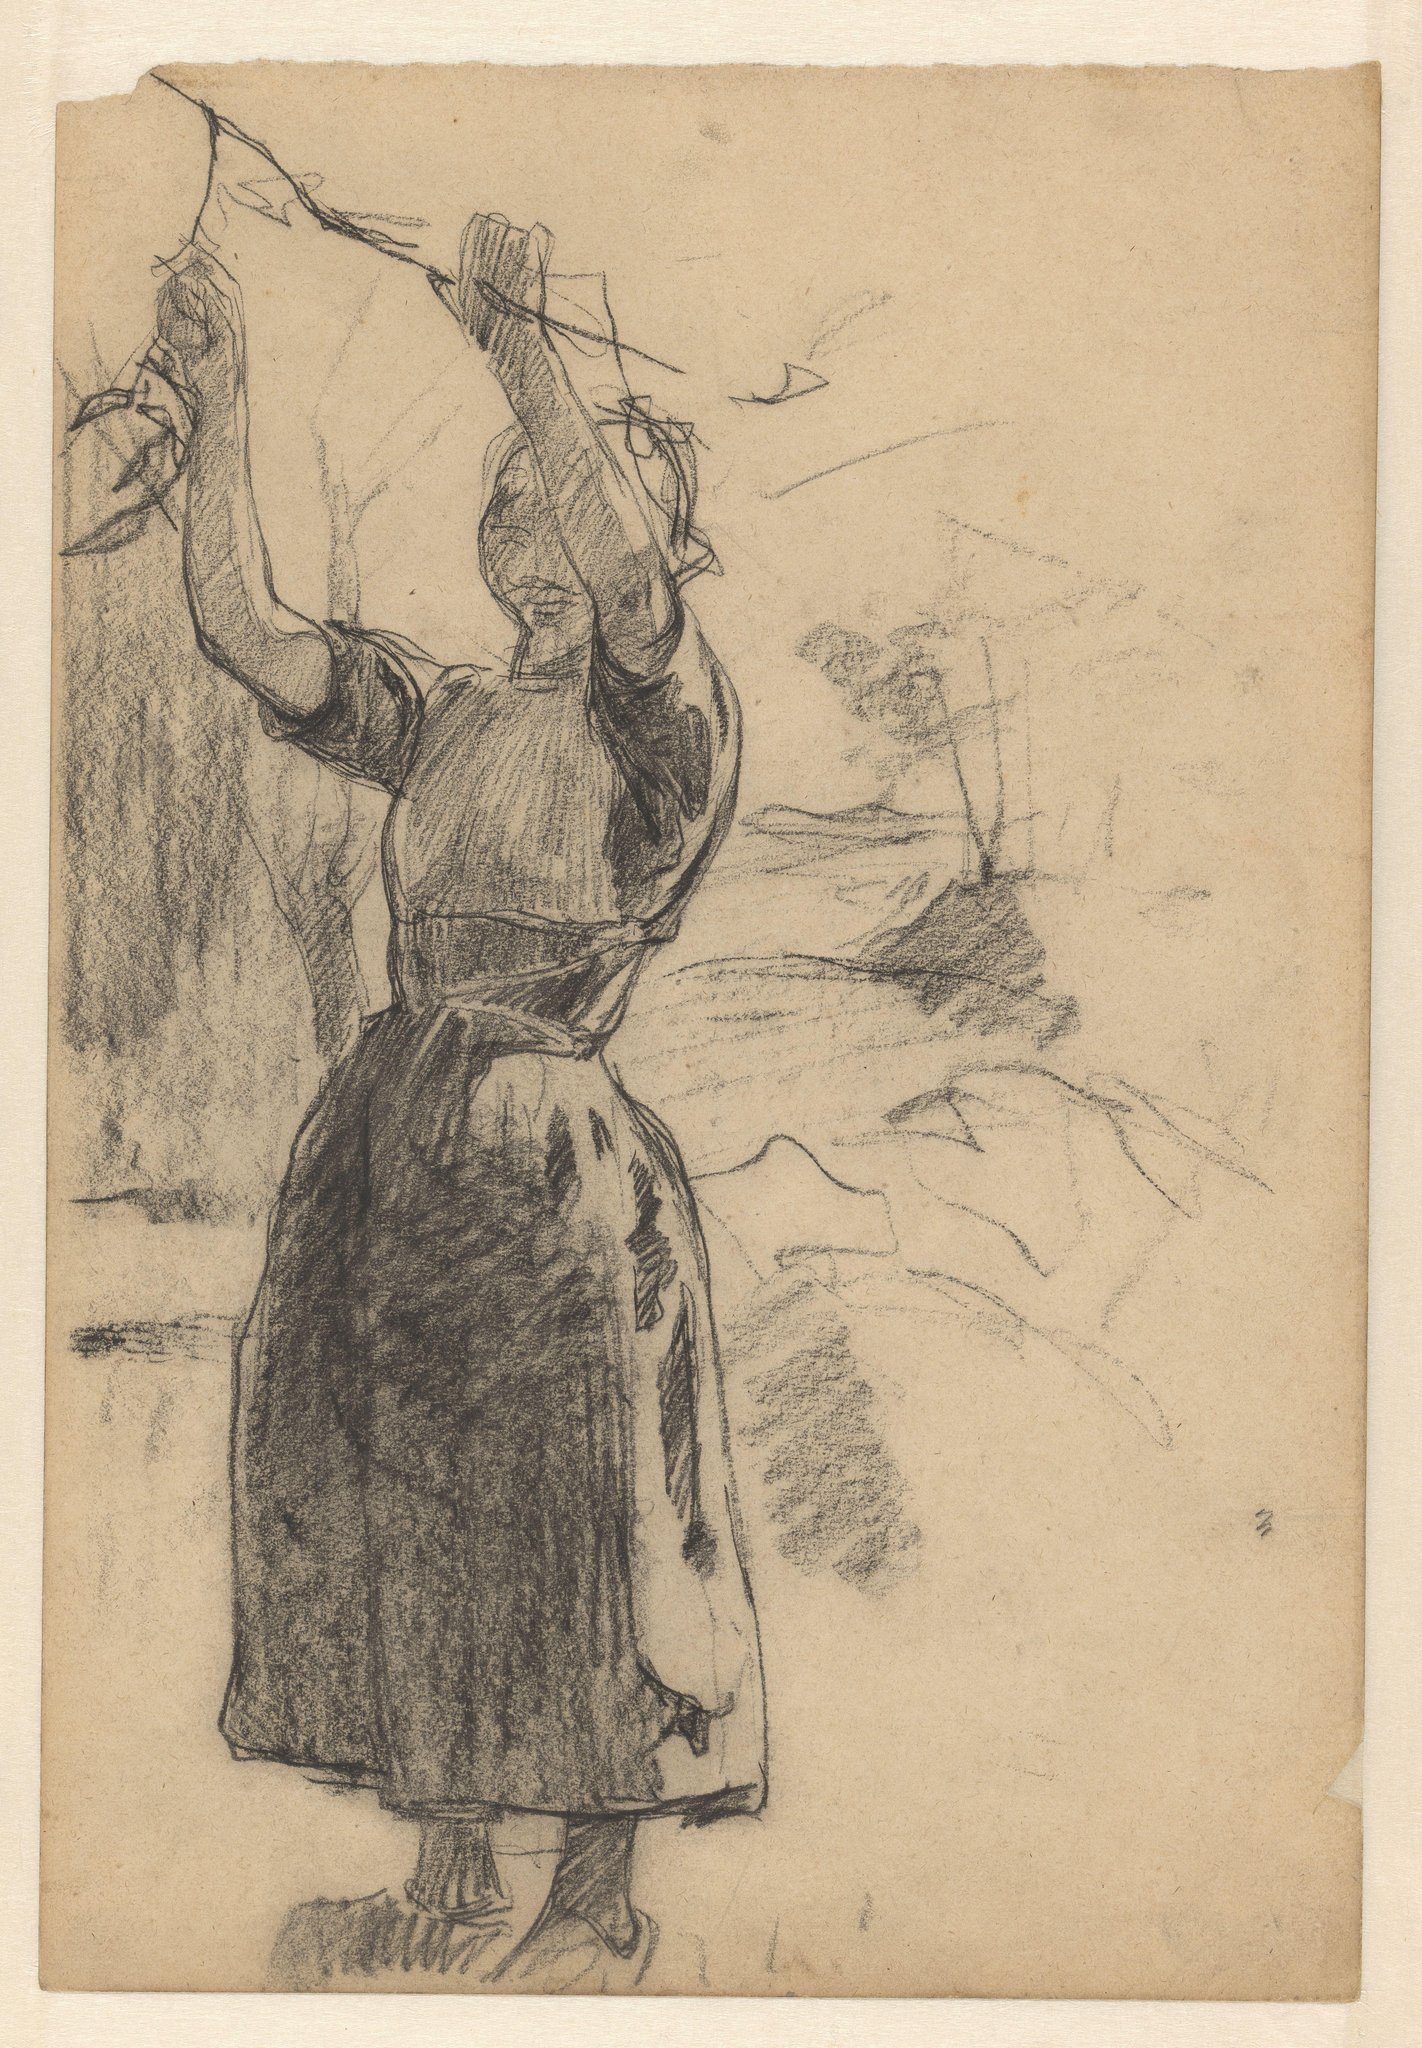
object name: drawing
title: Staande vrouw grijpt een boomtak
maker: willem witsen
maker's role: draughtsman, painter, print maker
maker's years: 1860-1923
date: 1870-1923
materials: chalk, paper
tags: wooden shoes, clogs, anonymous historical person portrayed alone - bb - woman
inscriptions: label: ‘W.F. / T. 32’